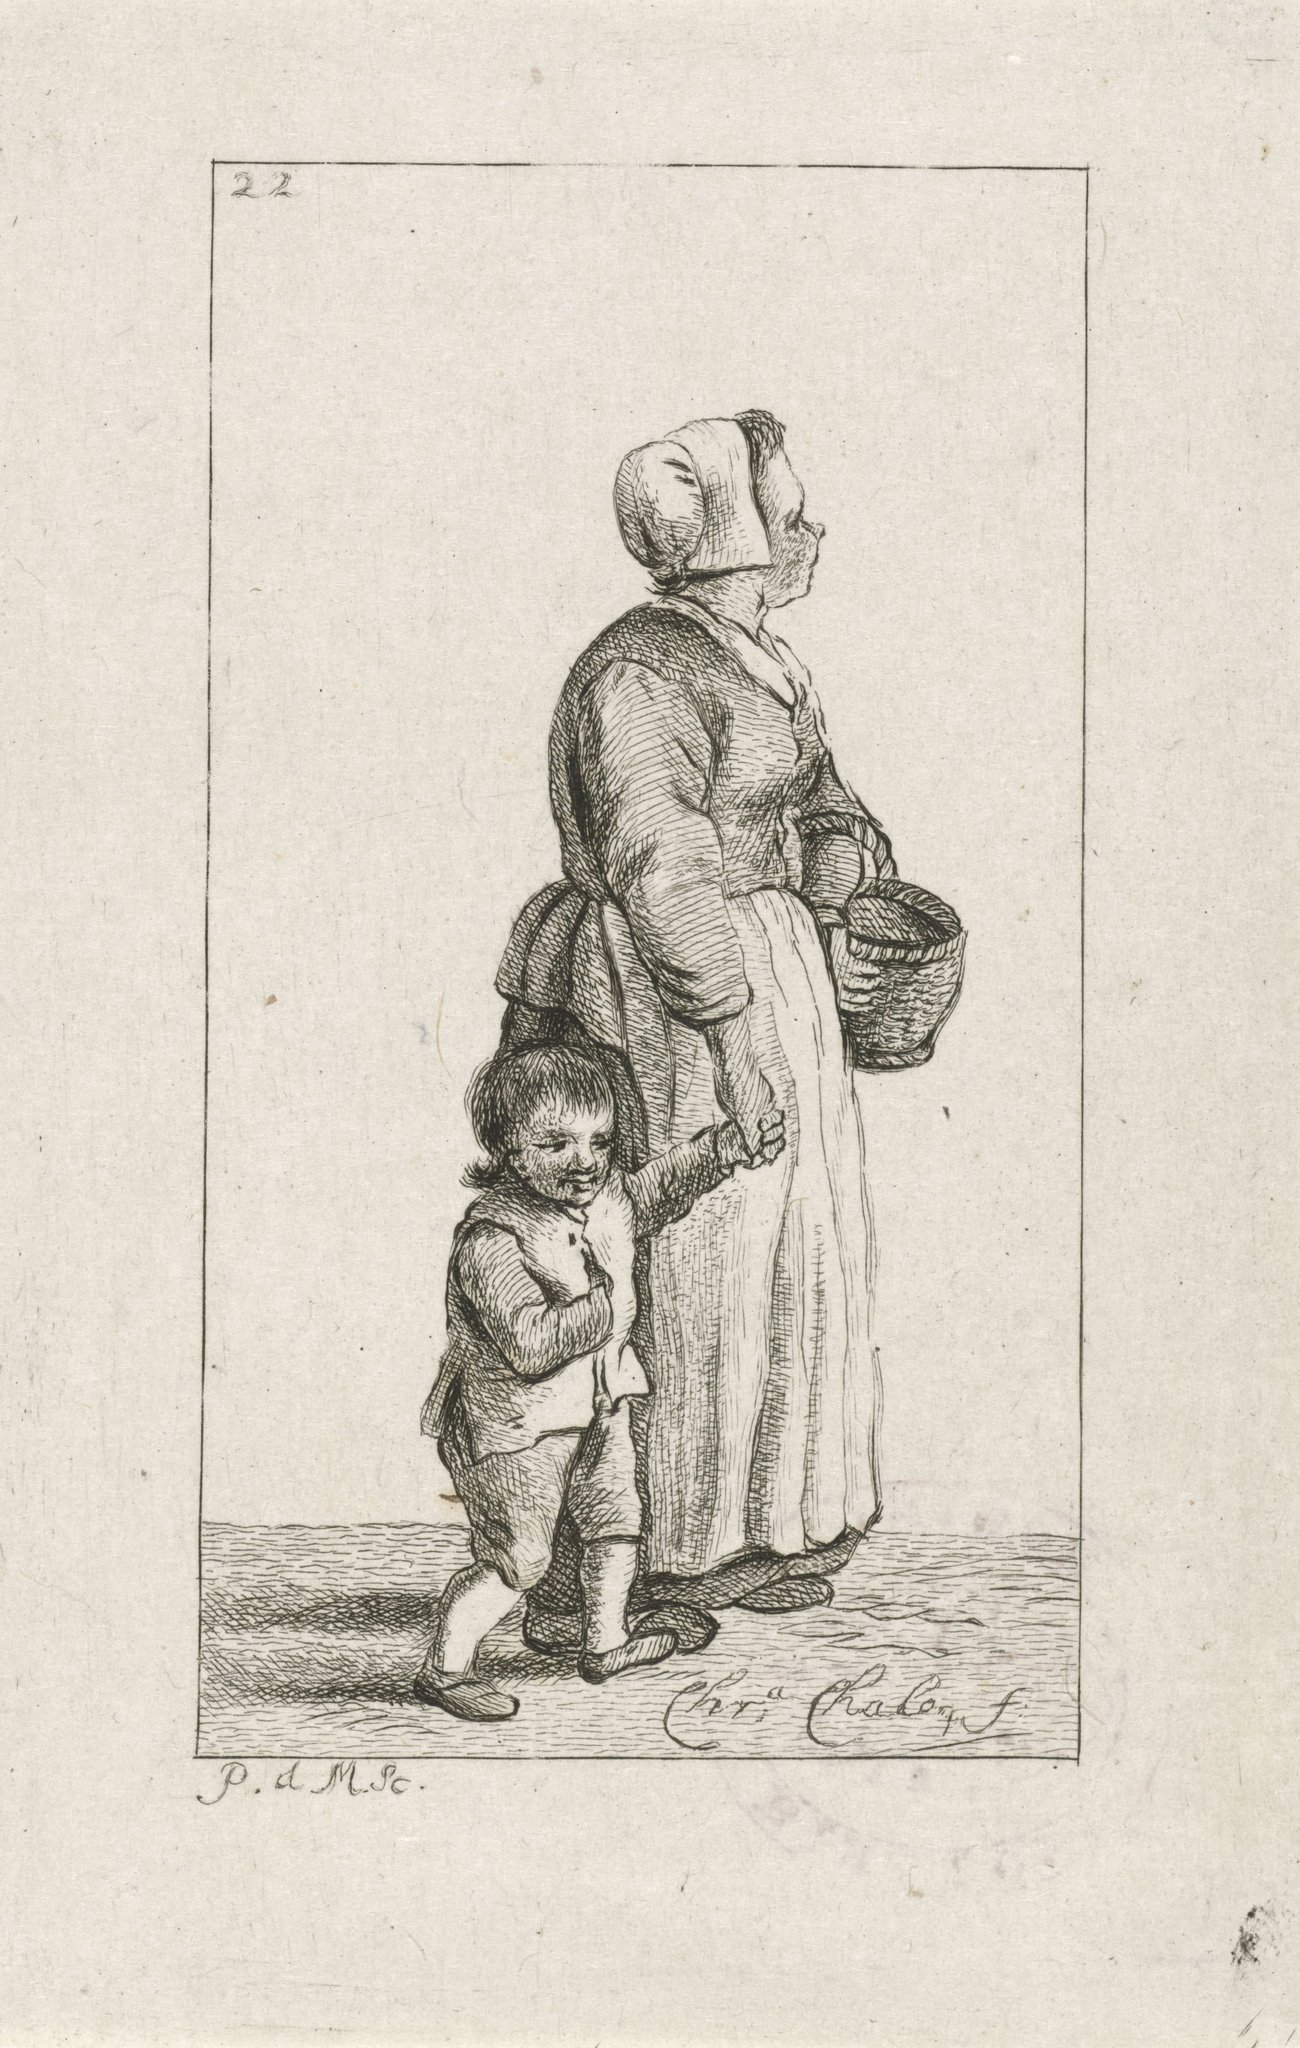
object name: print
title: Staande vrouw met kind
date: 1779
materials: paper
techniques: etching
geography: leiden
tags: parents with their children, mother and baby or young child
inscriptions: collector's mark: Lugt 240